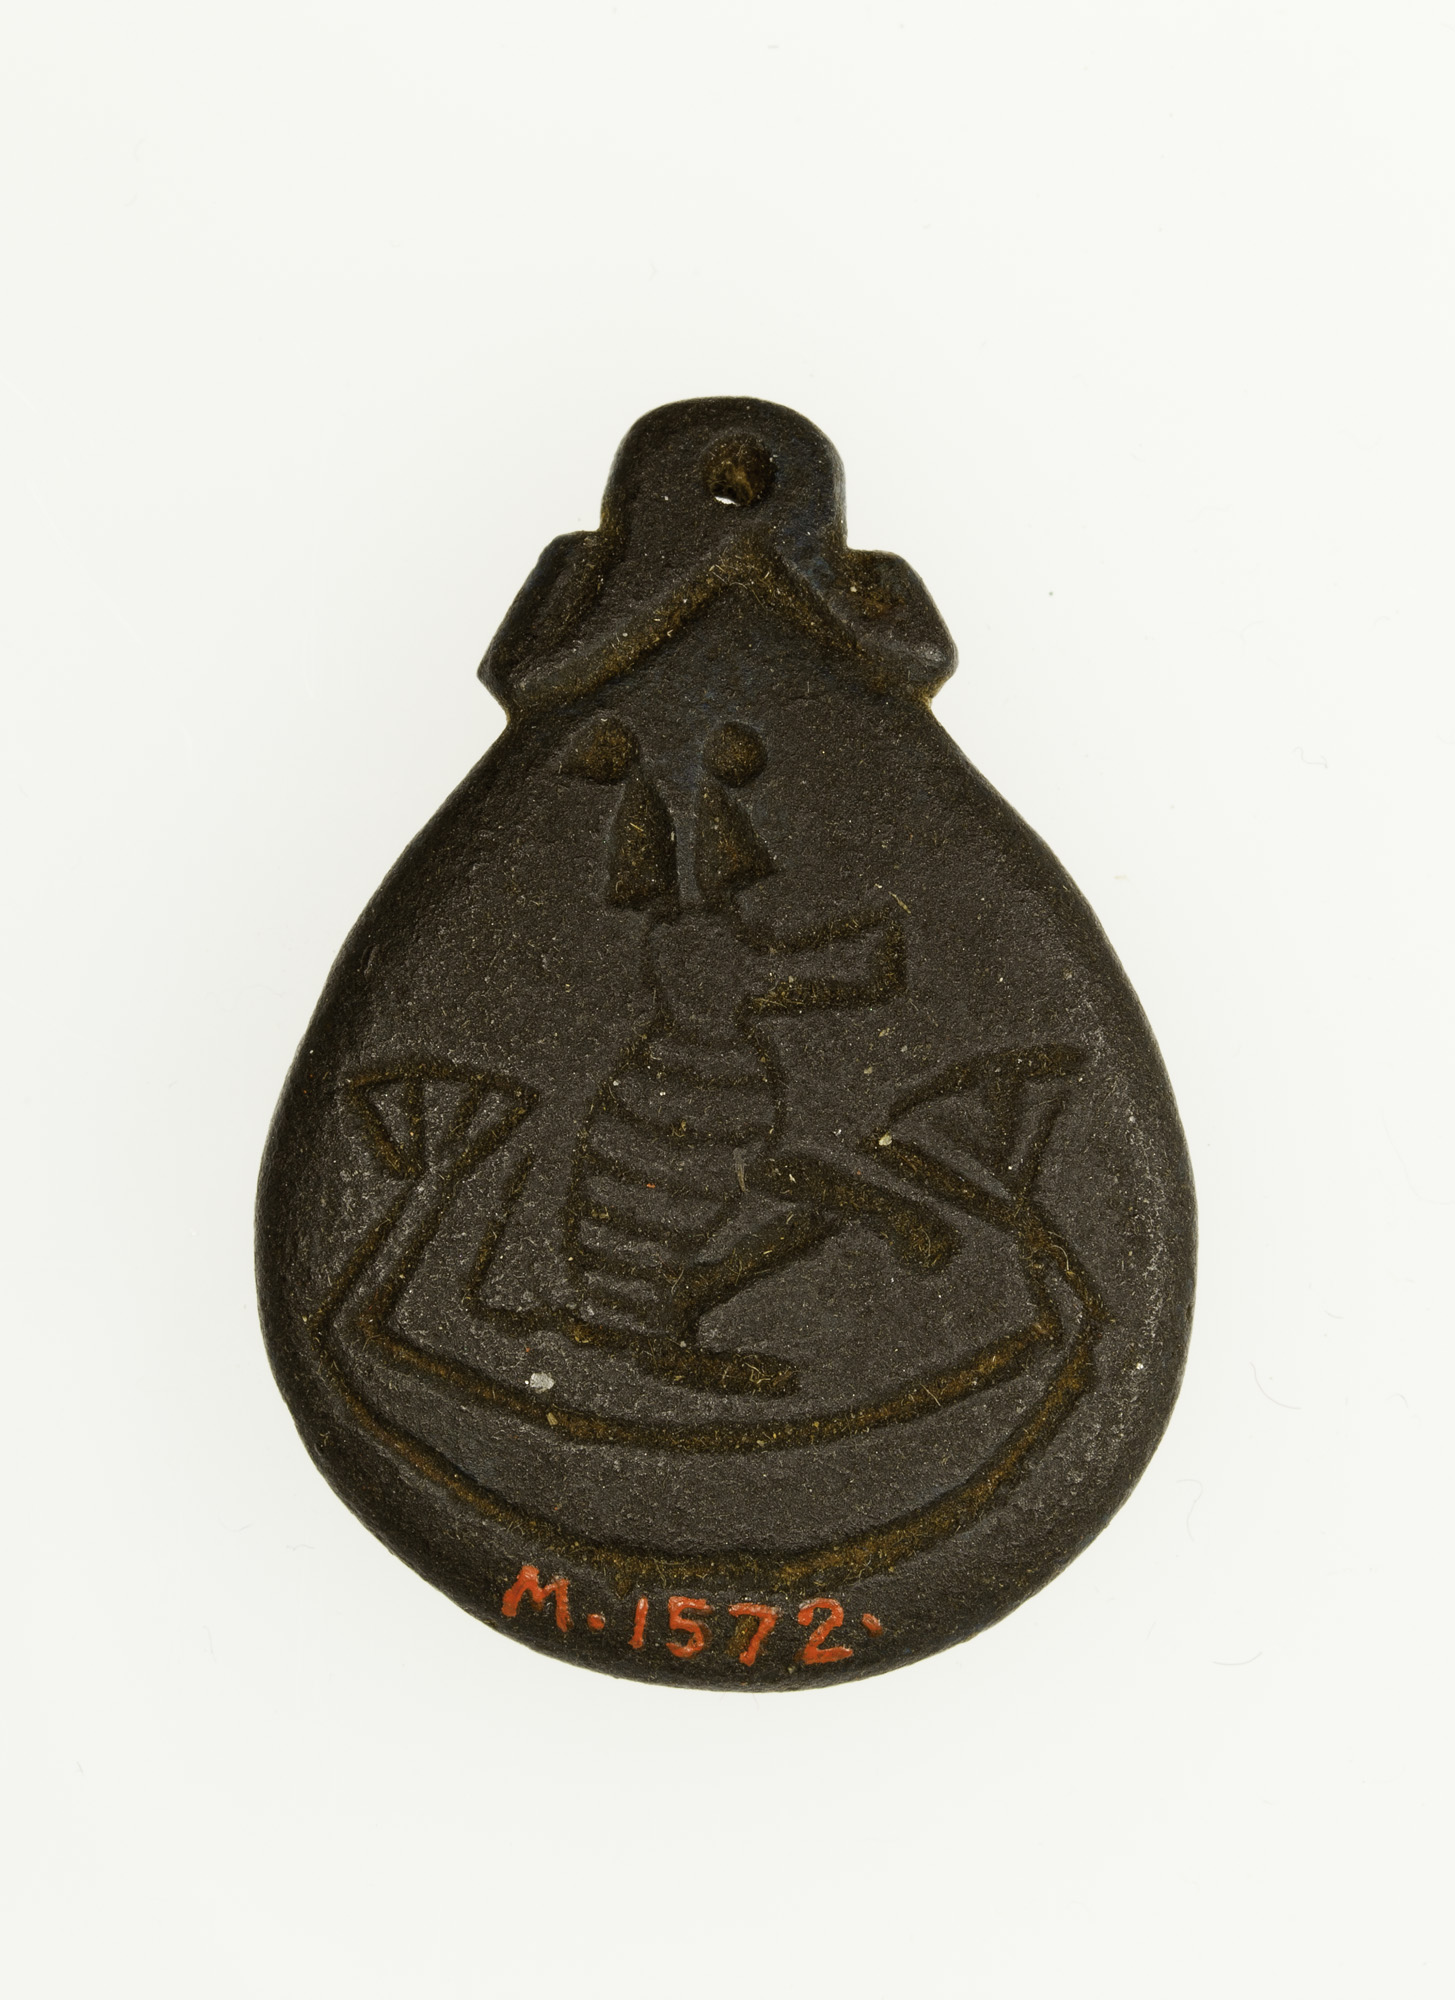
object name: amulet, baboon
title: Amulet illustrating a baboon in a boat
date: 304-30 BCE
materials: faience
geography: egypt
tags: boats,baboons